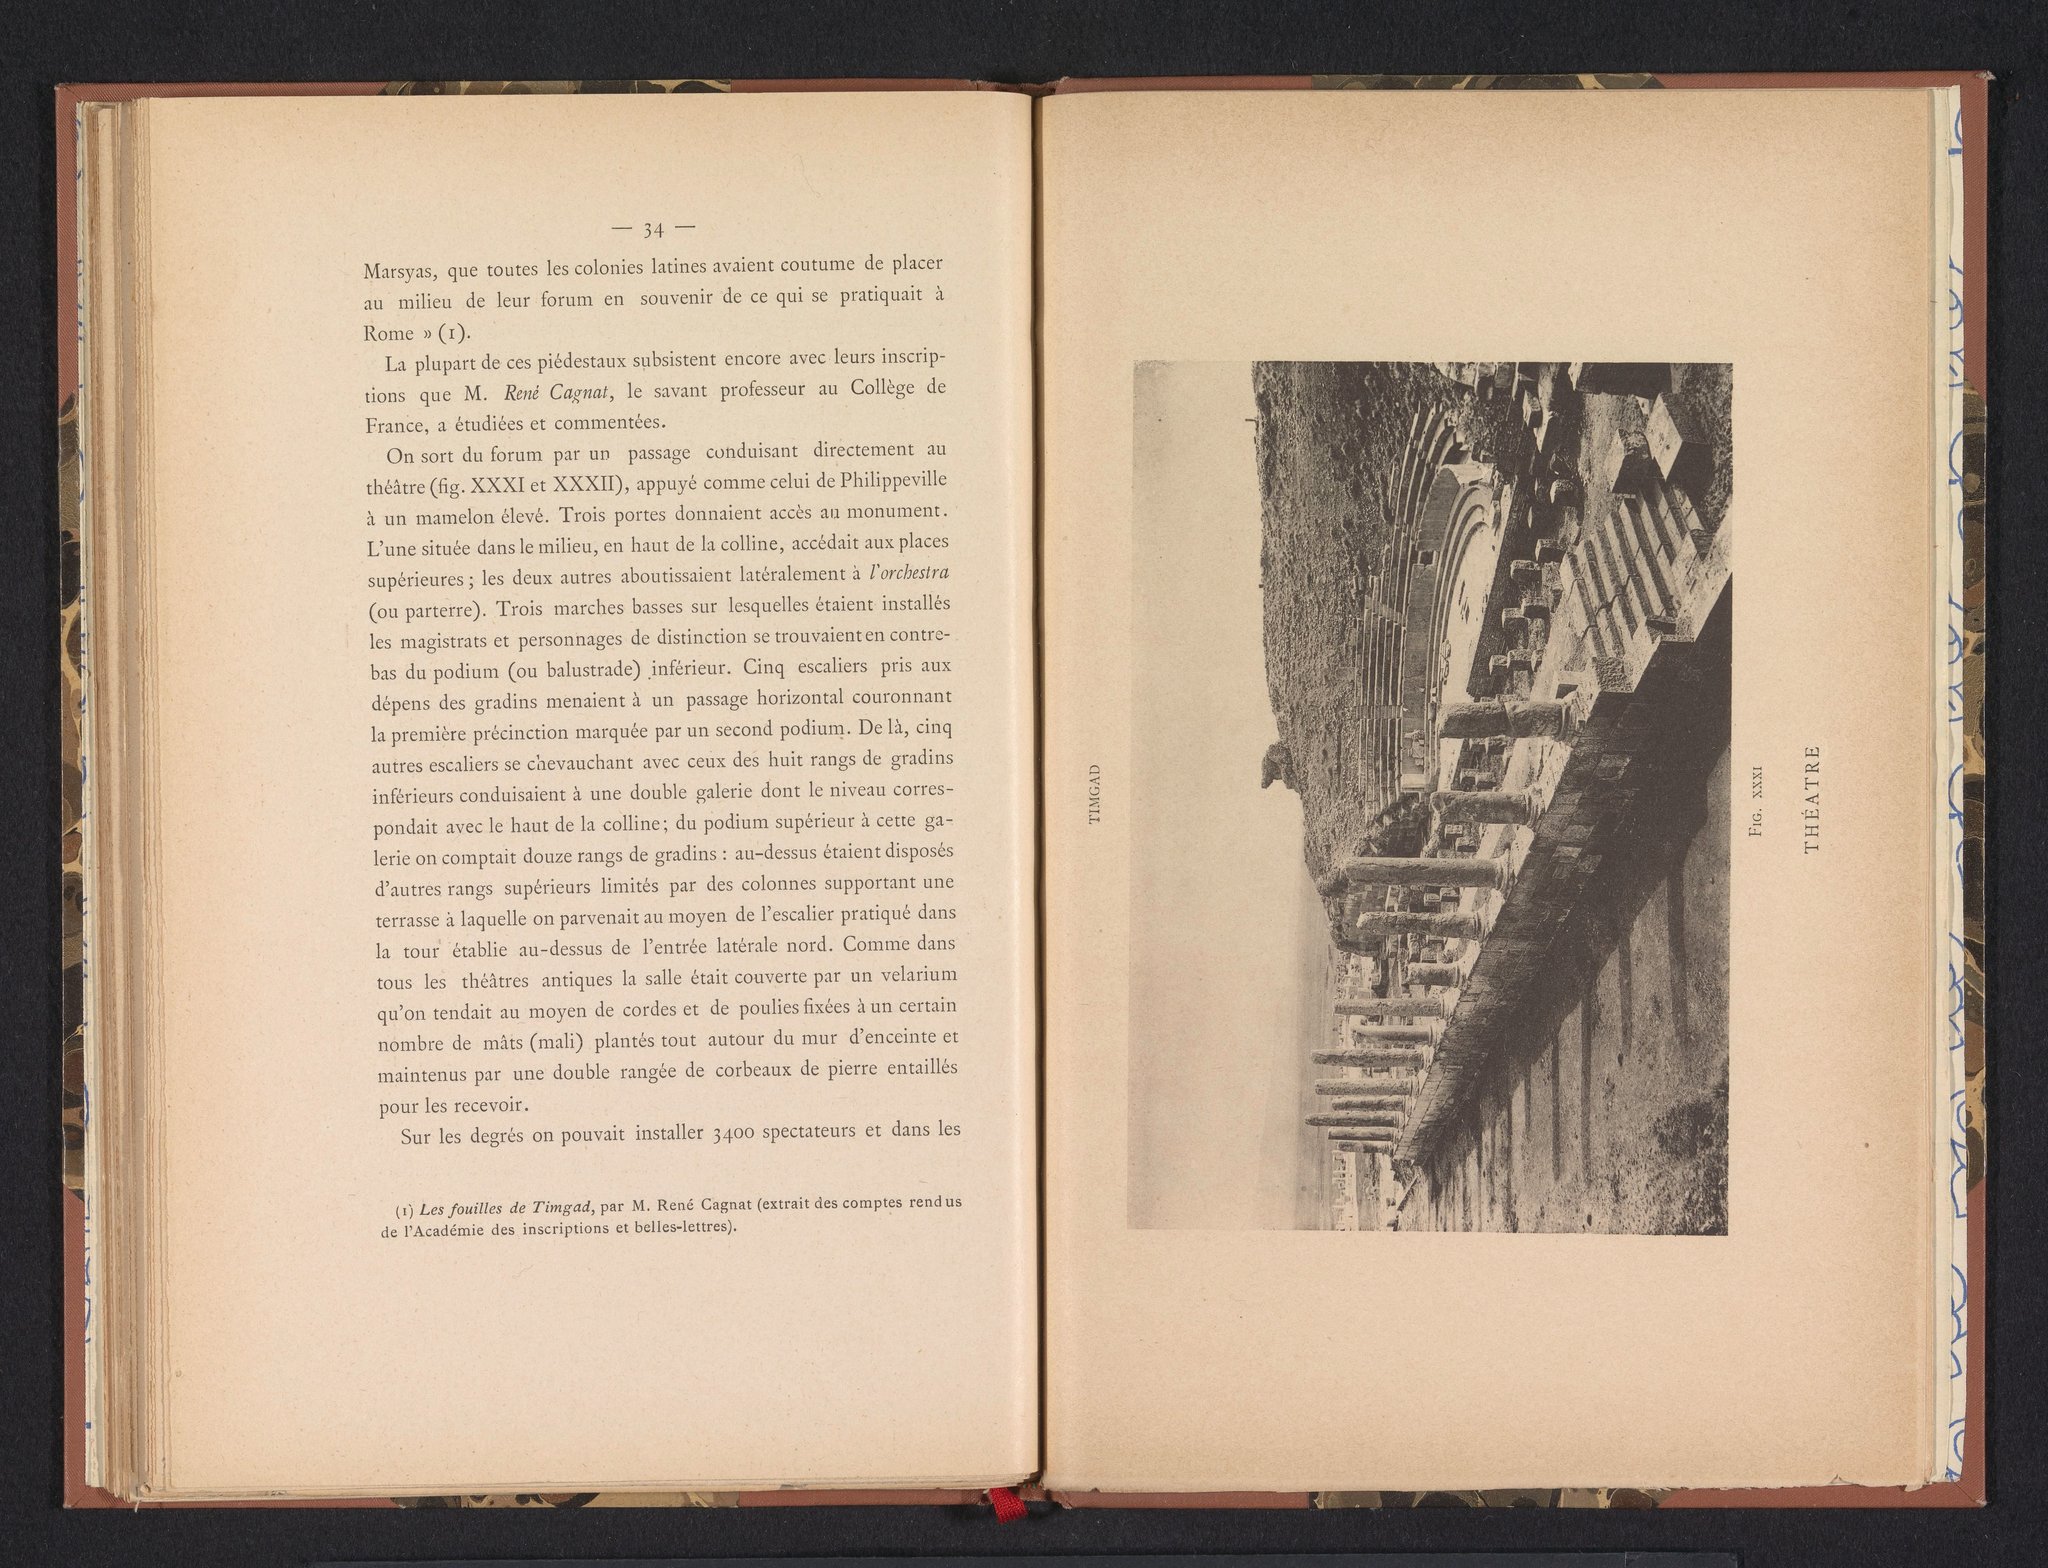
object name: photomechanical print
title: Théatre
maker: Anonymous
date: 1884-1894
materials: paper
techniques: photograph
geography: timgad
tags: amphitheatre, landscape with ruins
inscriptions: number: ‘Fig. XXXI’